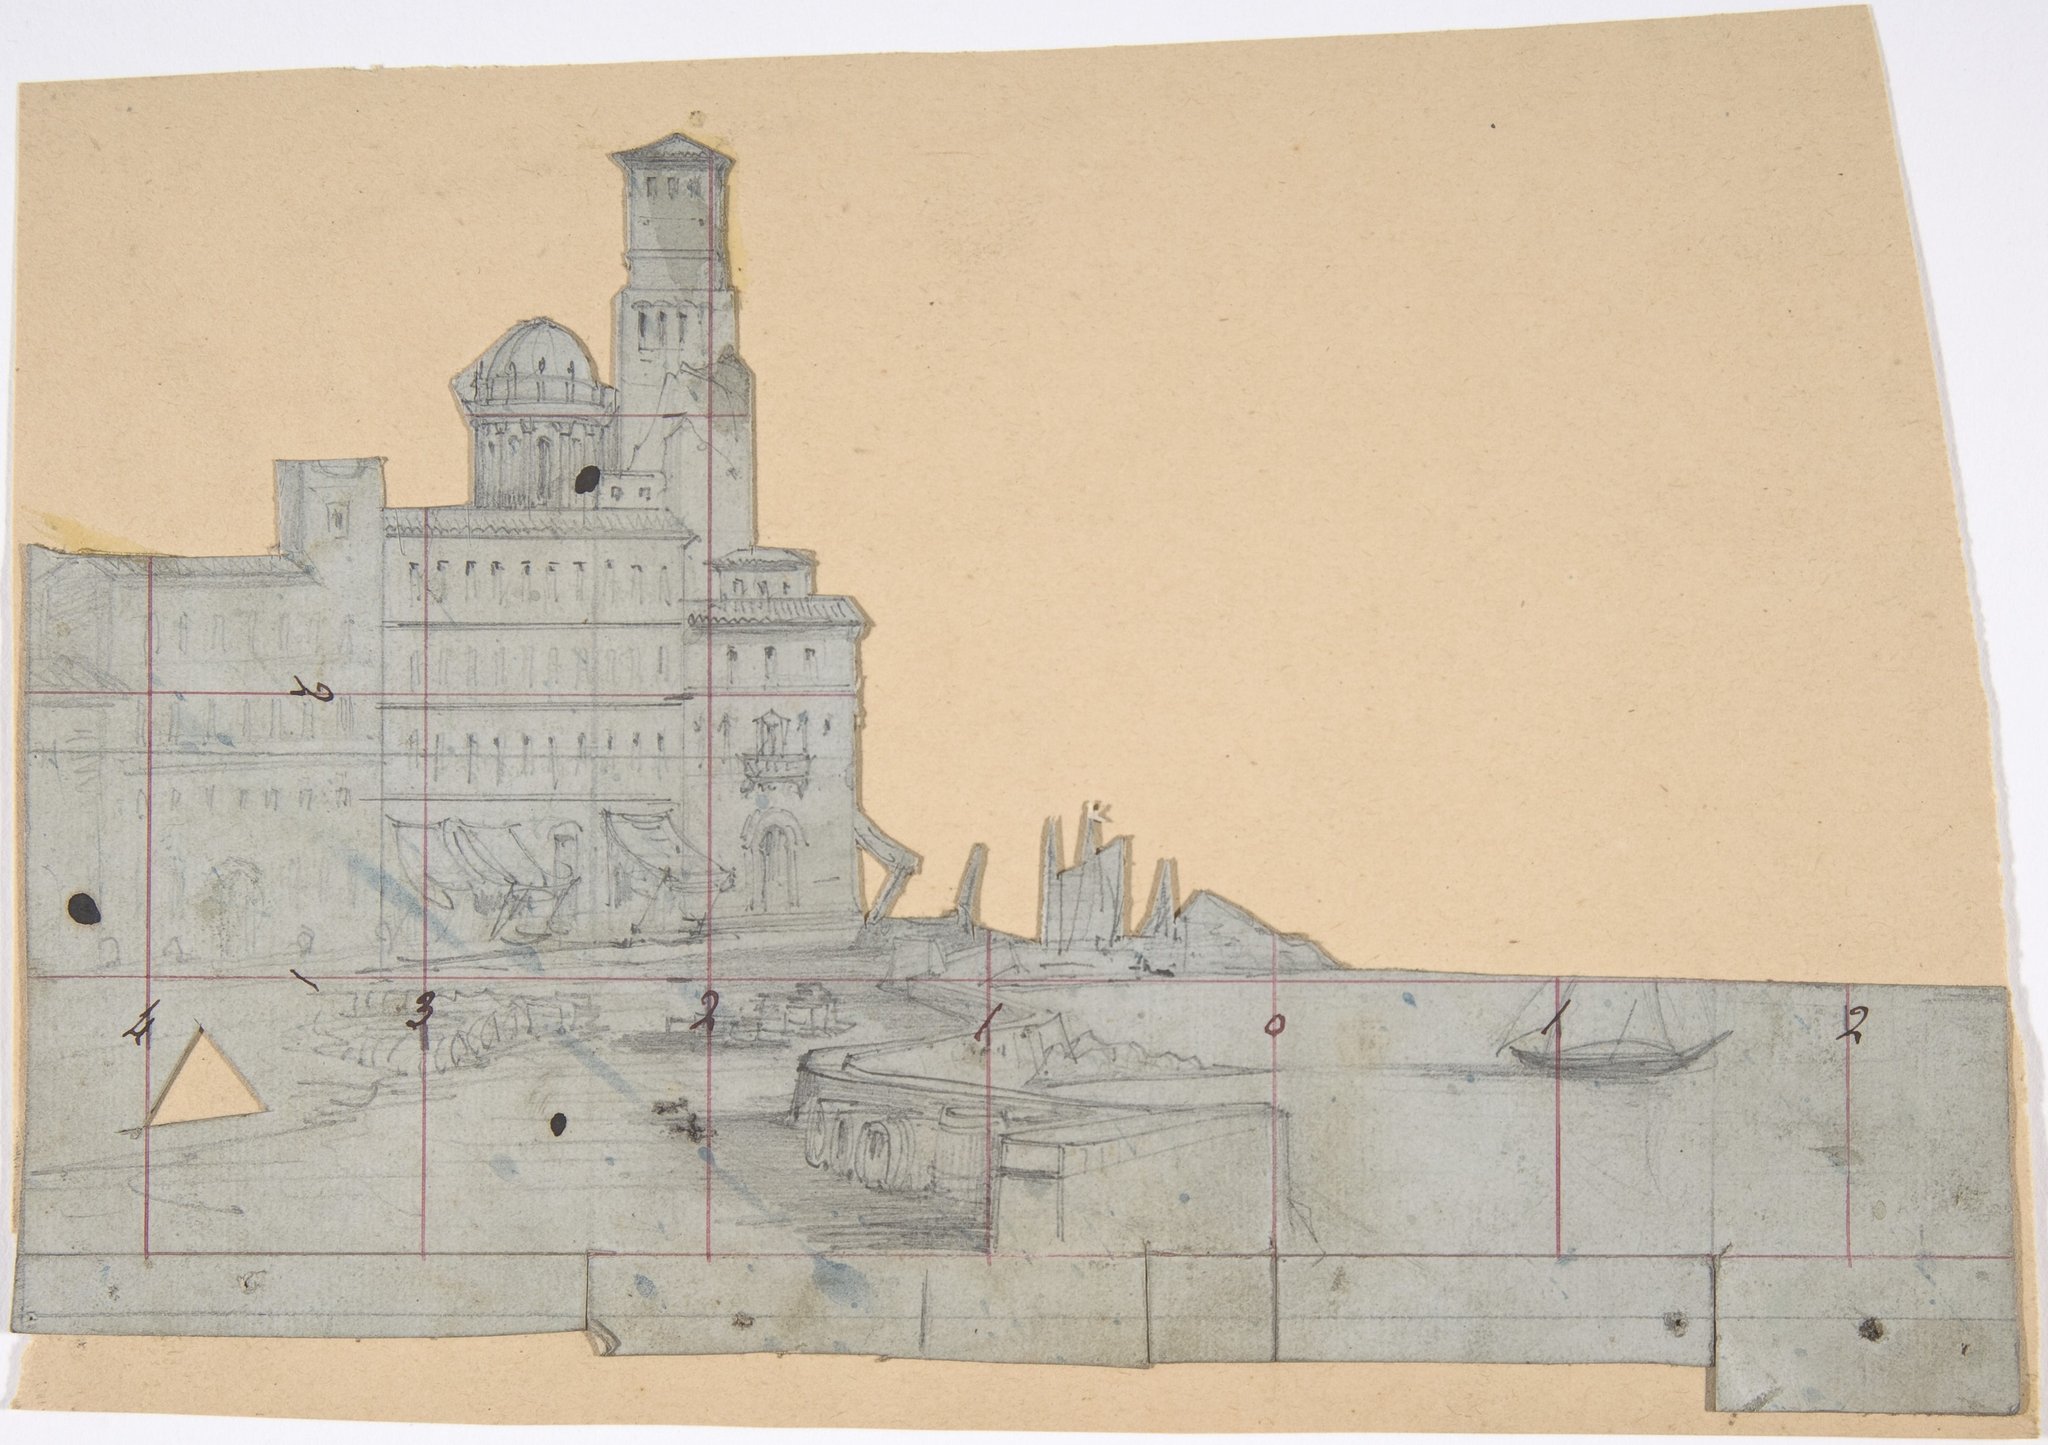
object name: drawing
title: Design for a Stage Set at the Opéra, Paris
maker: eugène cicéri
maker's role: artist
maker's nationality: french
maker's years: 1813-1890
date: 1830-1890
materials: graphite, ink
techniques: pen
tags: buildings,boats,stage design